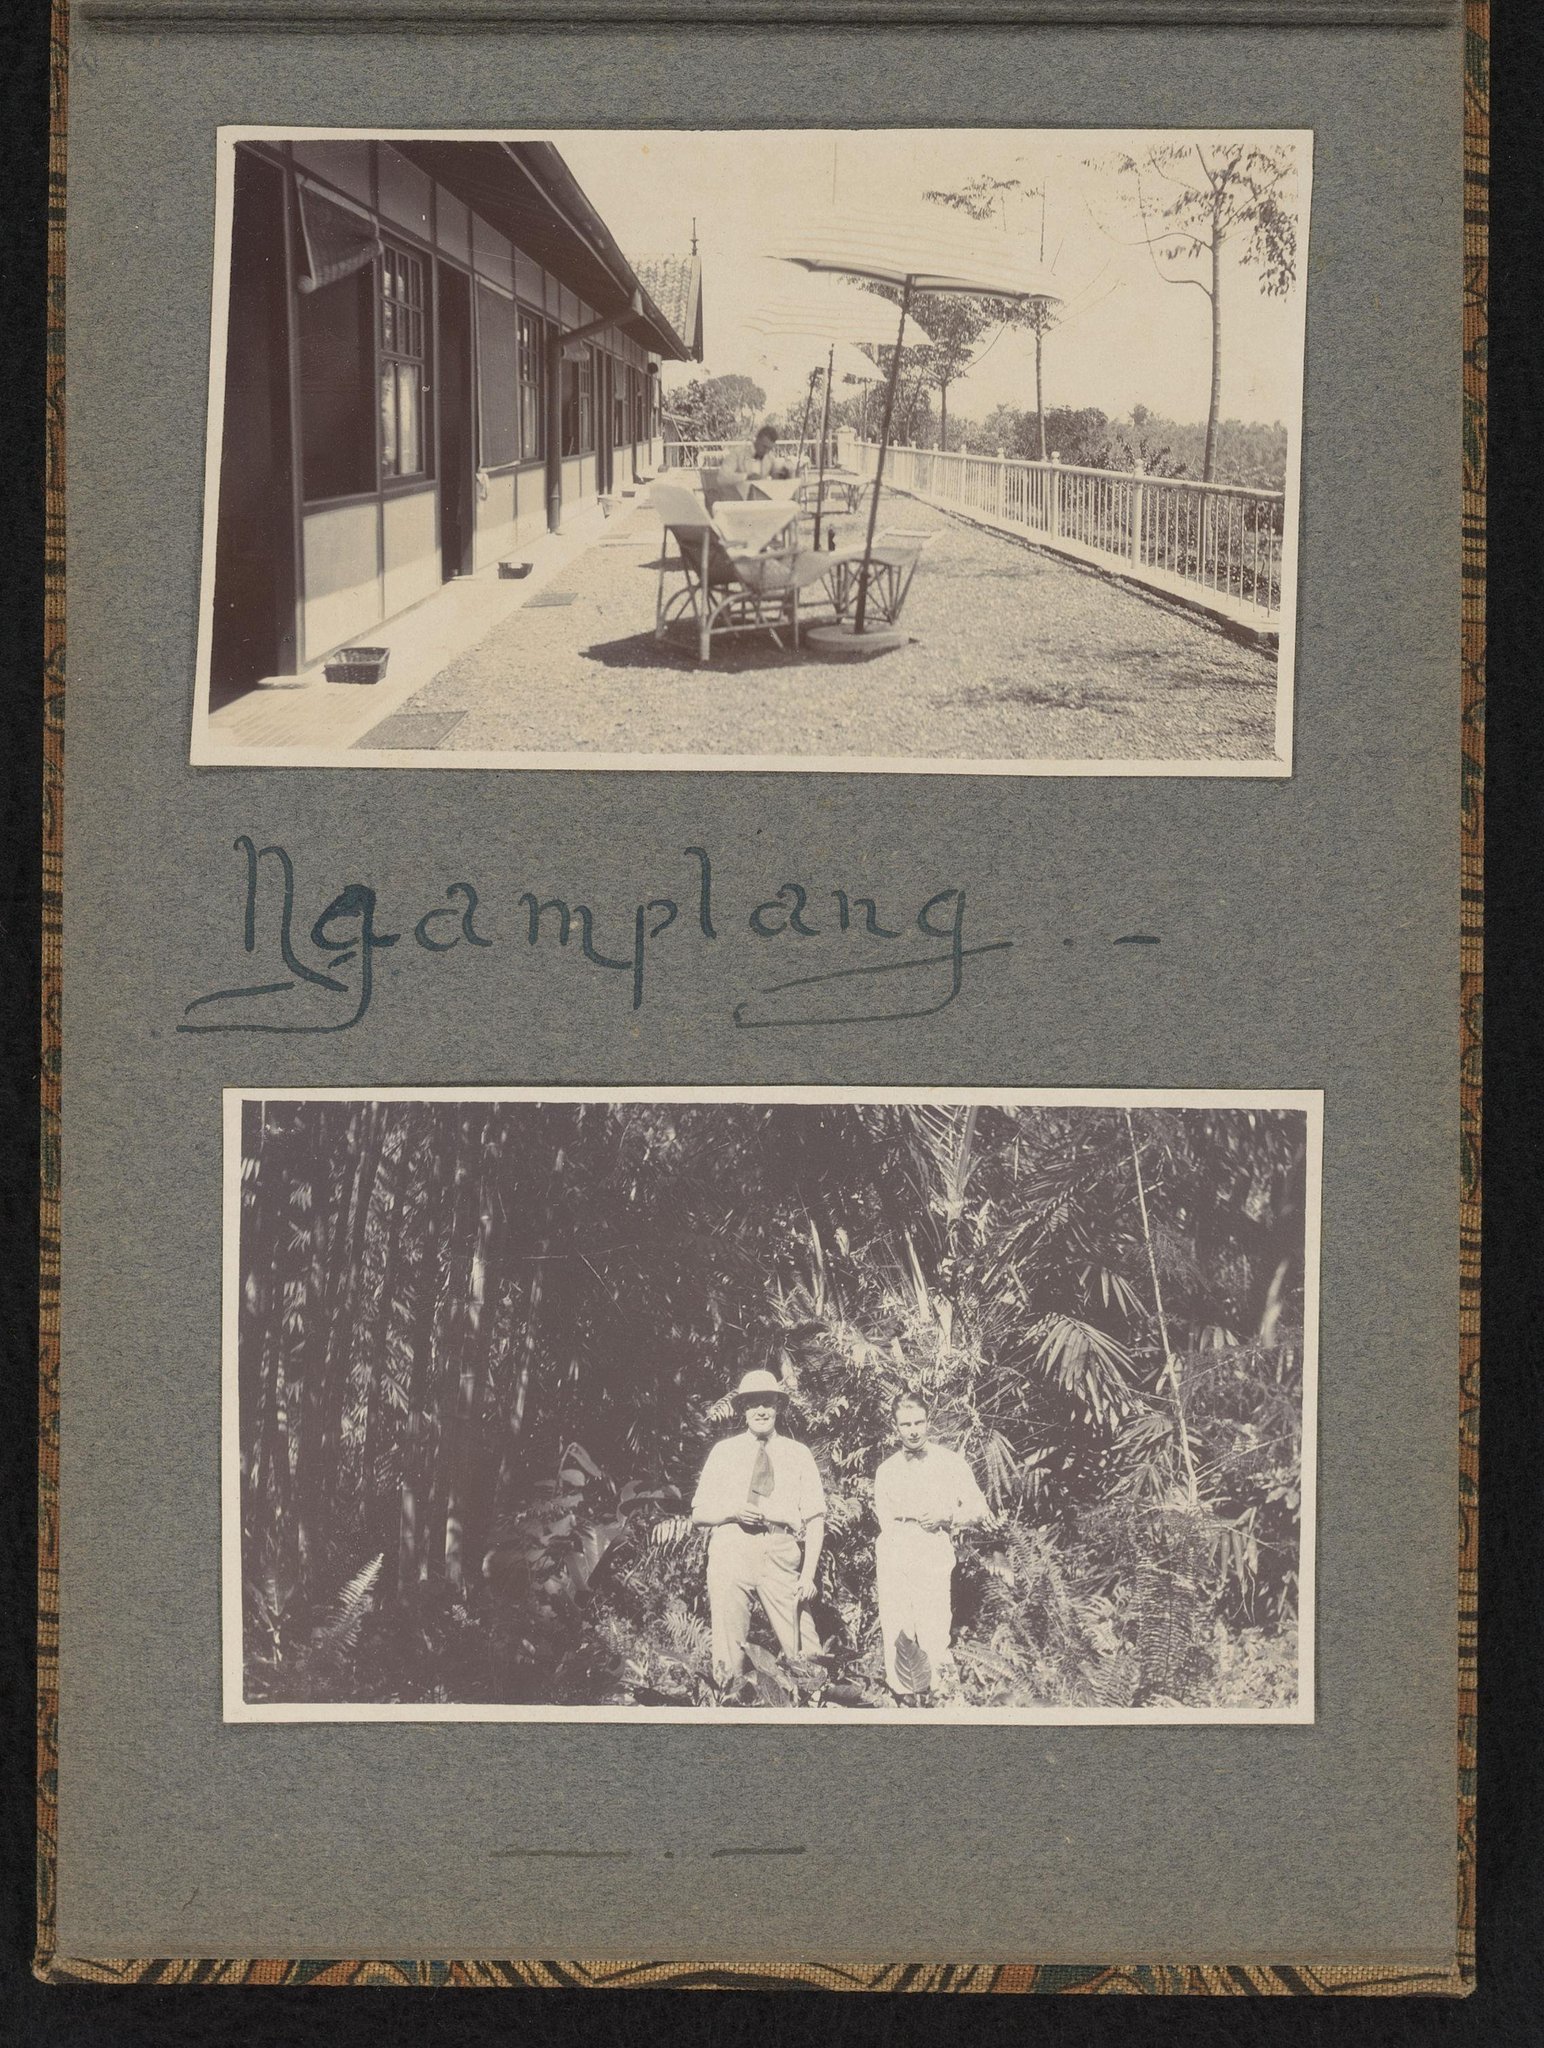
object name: photograph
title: Karel Frederik van den Berg met een van zijn twee zoons in Ngamplang, Garut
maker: karel frederik van den berg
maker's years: 1873-1948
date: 1921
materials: paper, cardboard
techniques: gelatin silver print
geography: ngamplang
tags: batavia, karel frederik van den berg, jungle, father and son(s) (family group)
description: Deze foto's zijn onderdeel van een album.